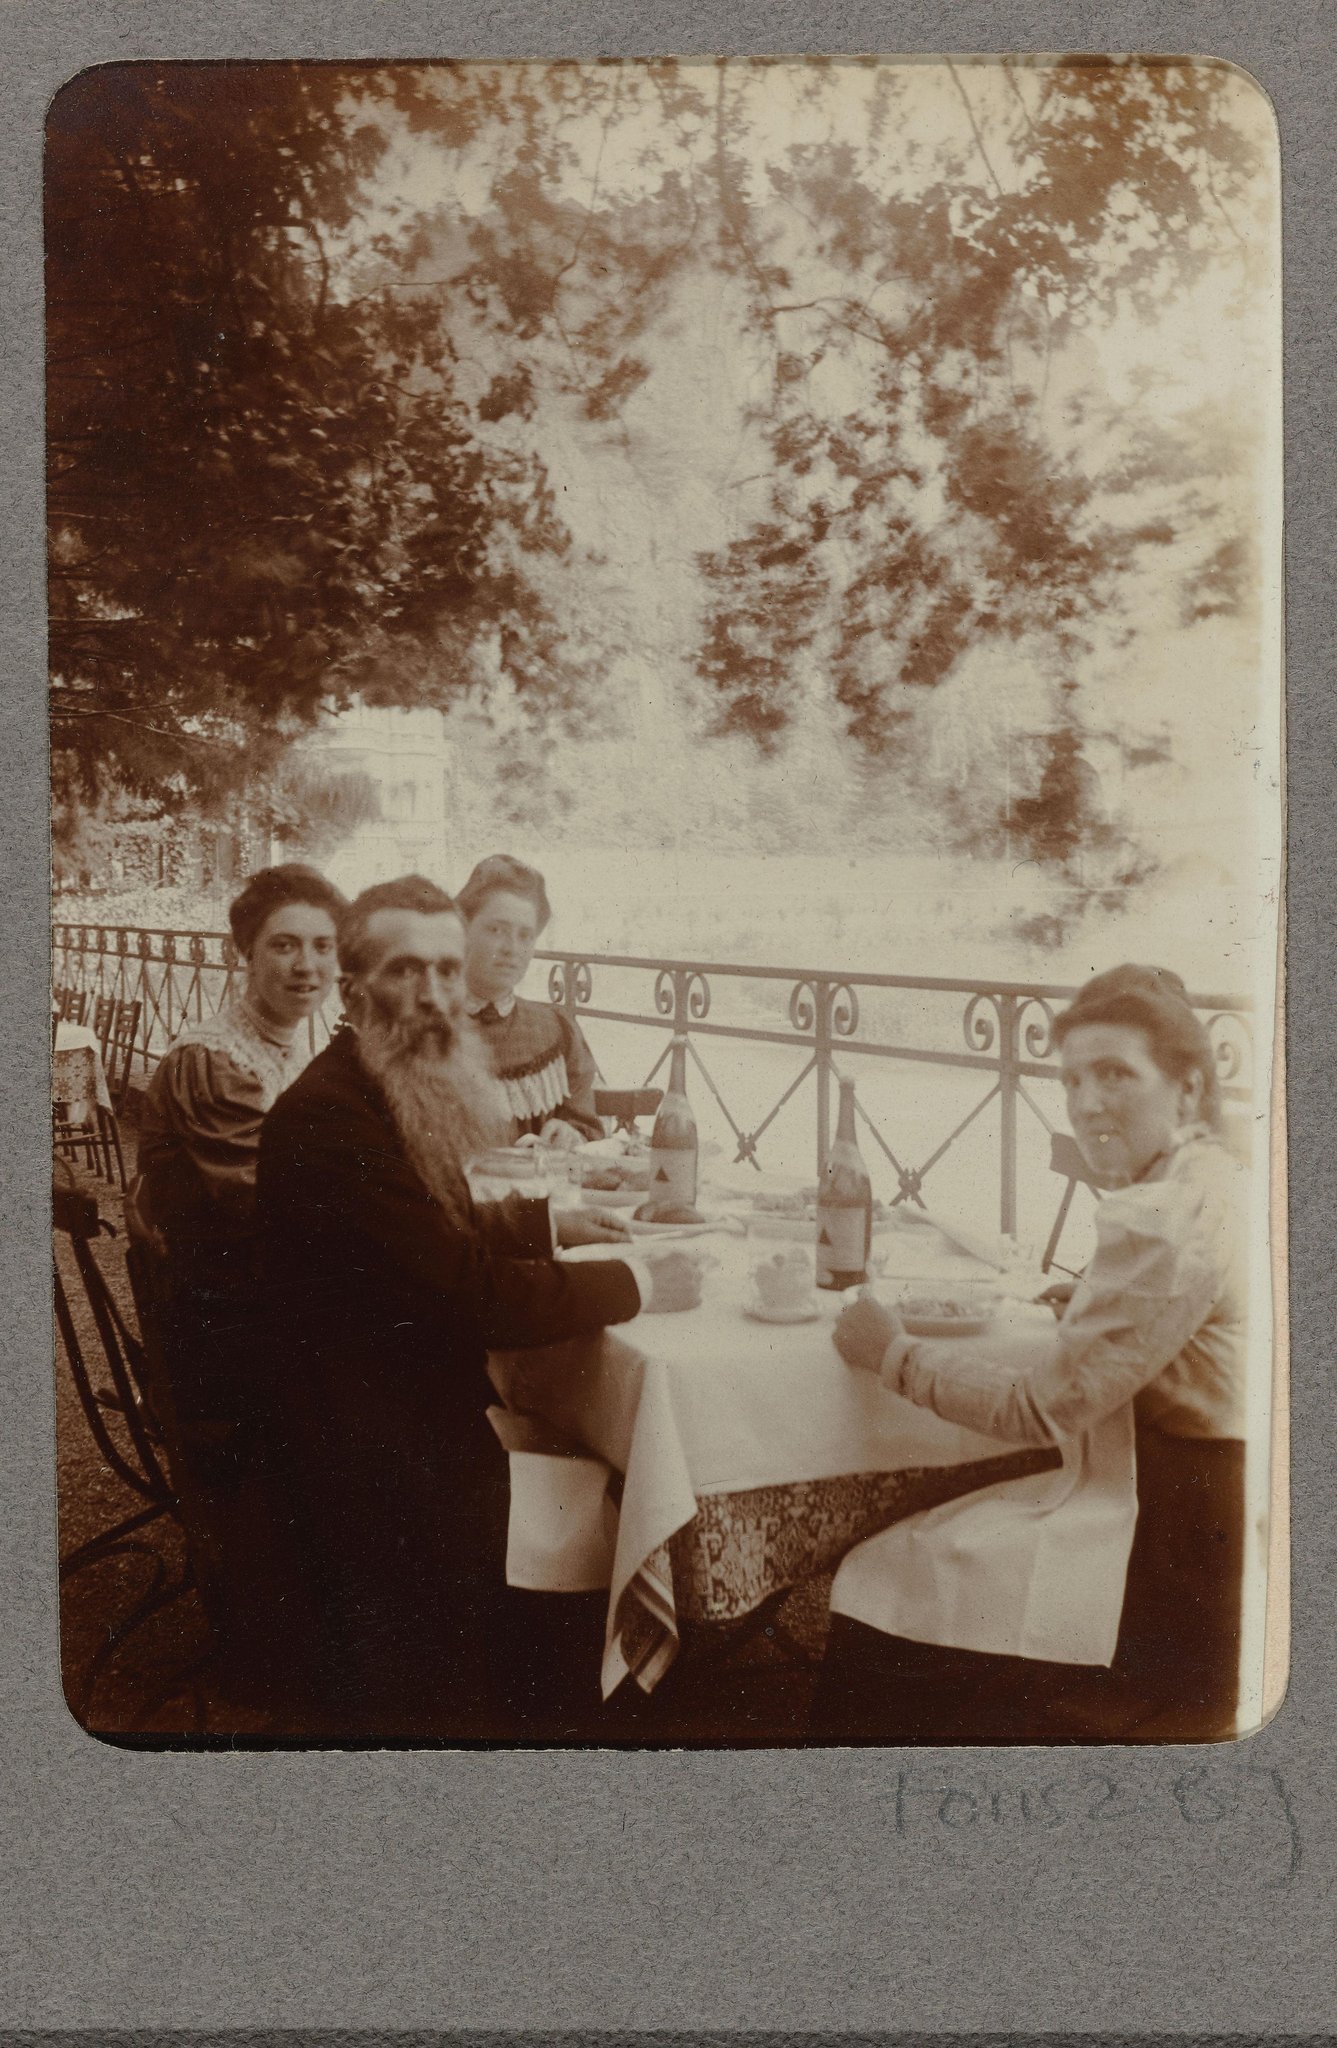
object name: photograph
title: Gezelschap dinerend op een terras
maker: christiaan otto roelofs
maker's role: fotograaf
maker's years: 1882-1970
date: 1900-1915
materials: photographic support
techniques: gelatin silver print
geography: netherlands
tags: evening meal, dinner, supper - cc - out of doors, historical persons